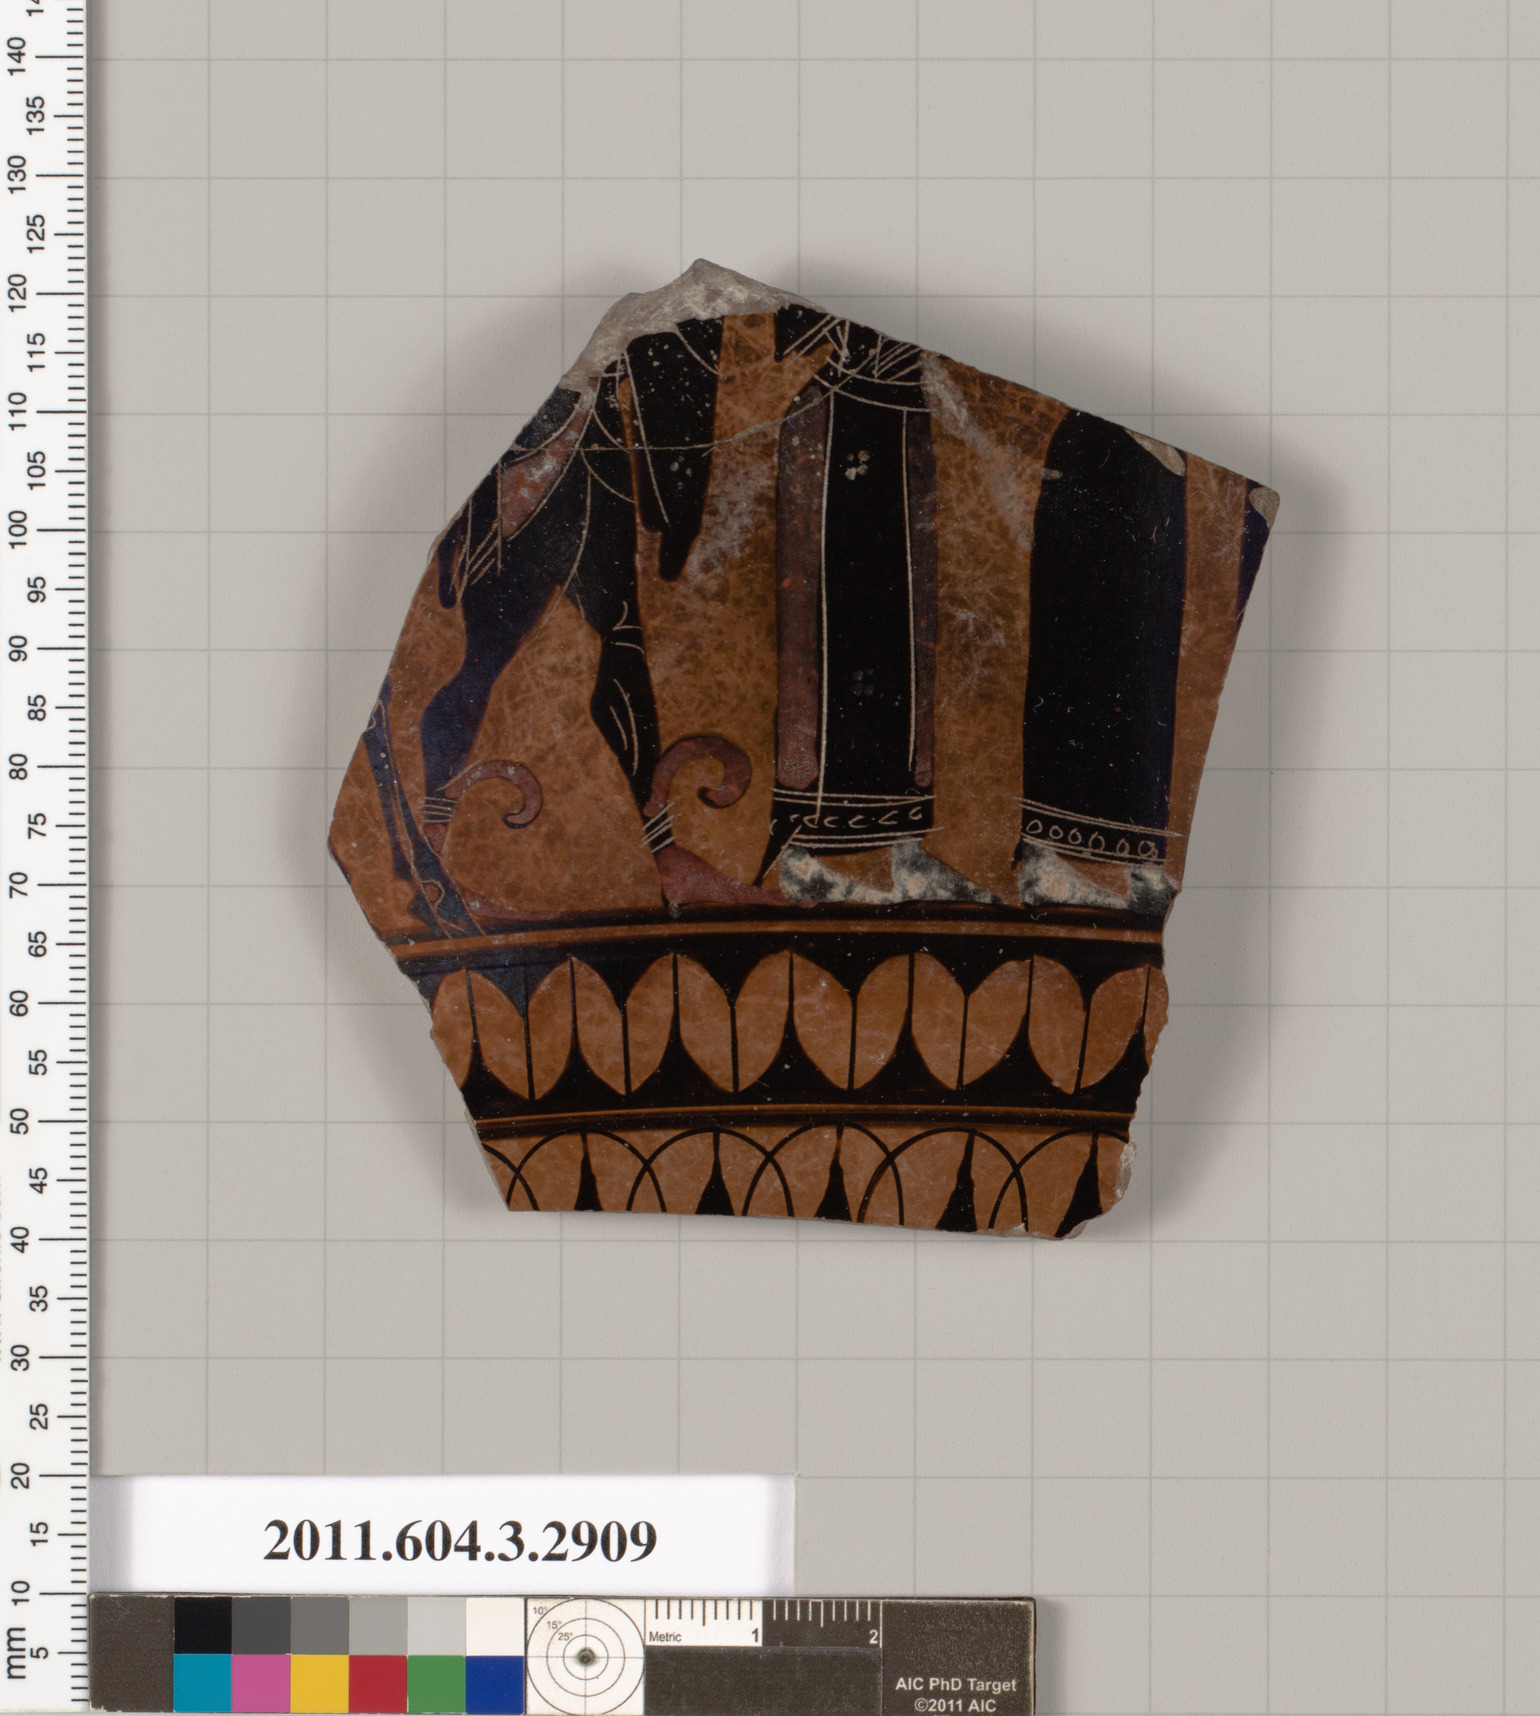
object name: pyxis fragment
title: Terracotta fragment of an Nicosthenic pyxis (box)?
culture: greek, attic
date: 550-526 BCE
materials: terracotta